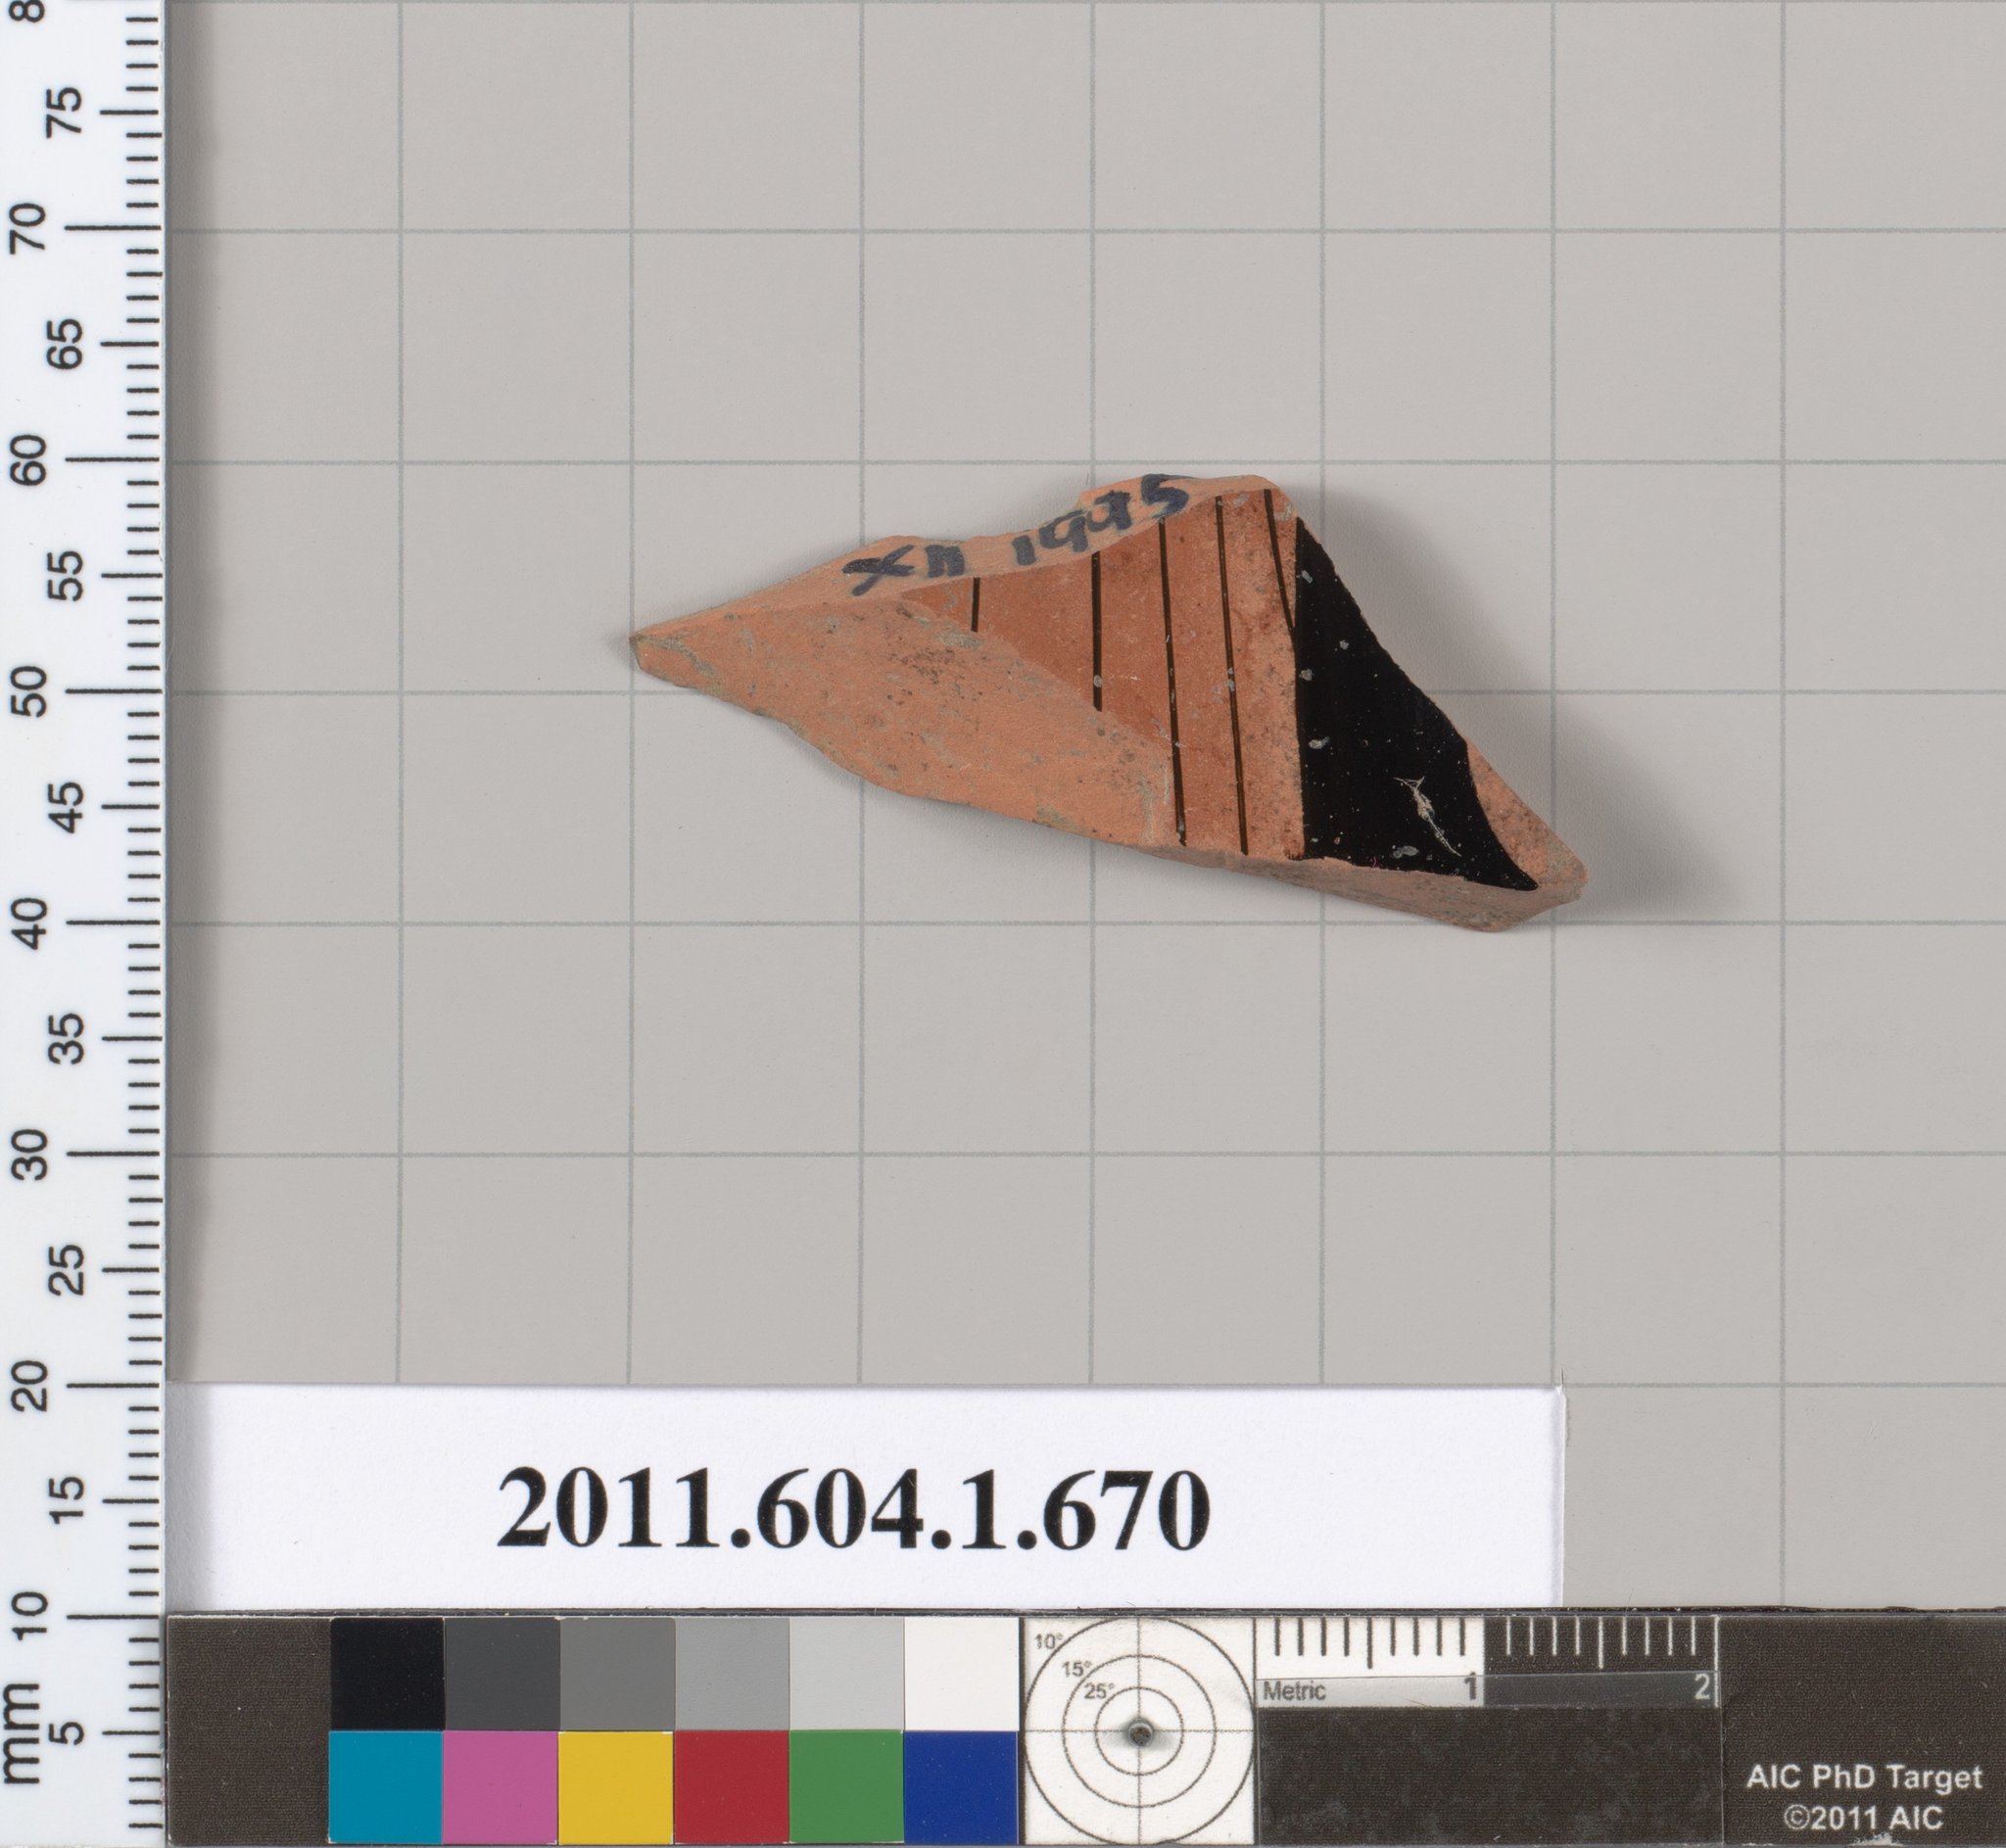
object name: kylix fragment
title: Terracotta fragment of a kylix (drinking cup)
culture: greek, attic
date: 475-451 BCE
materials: terracotta